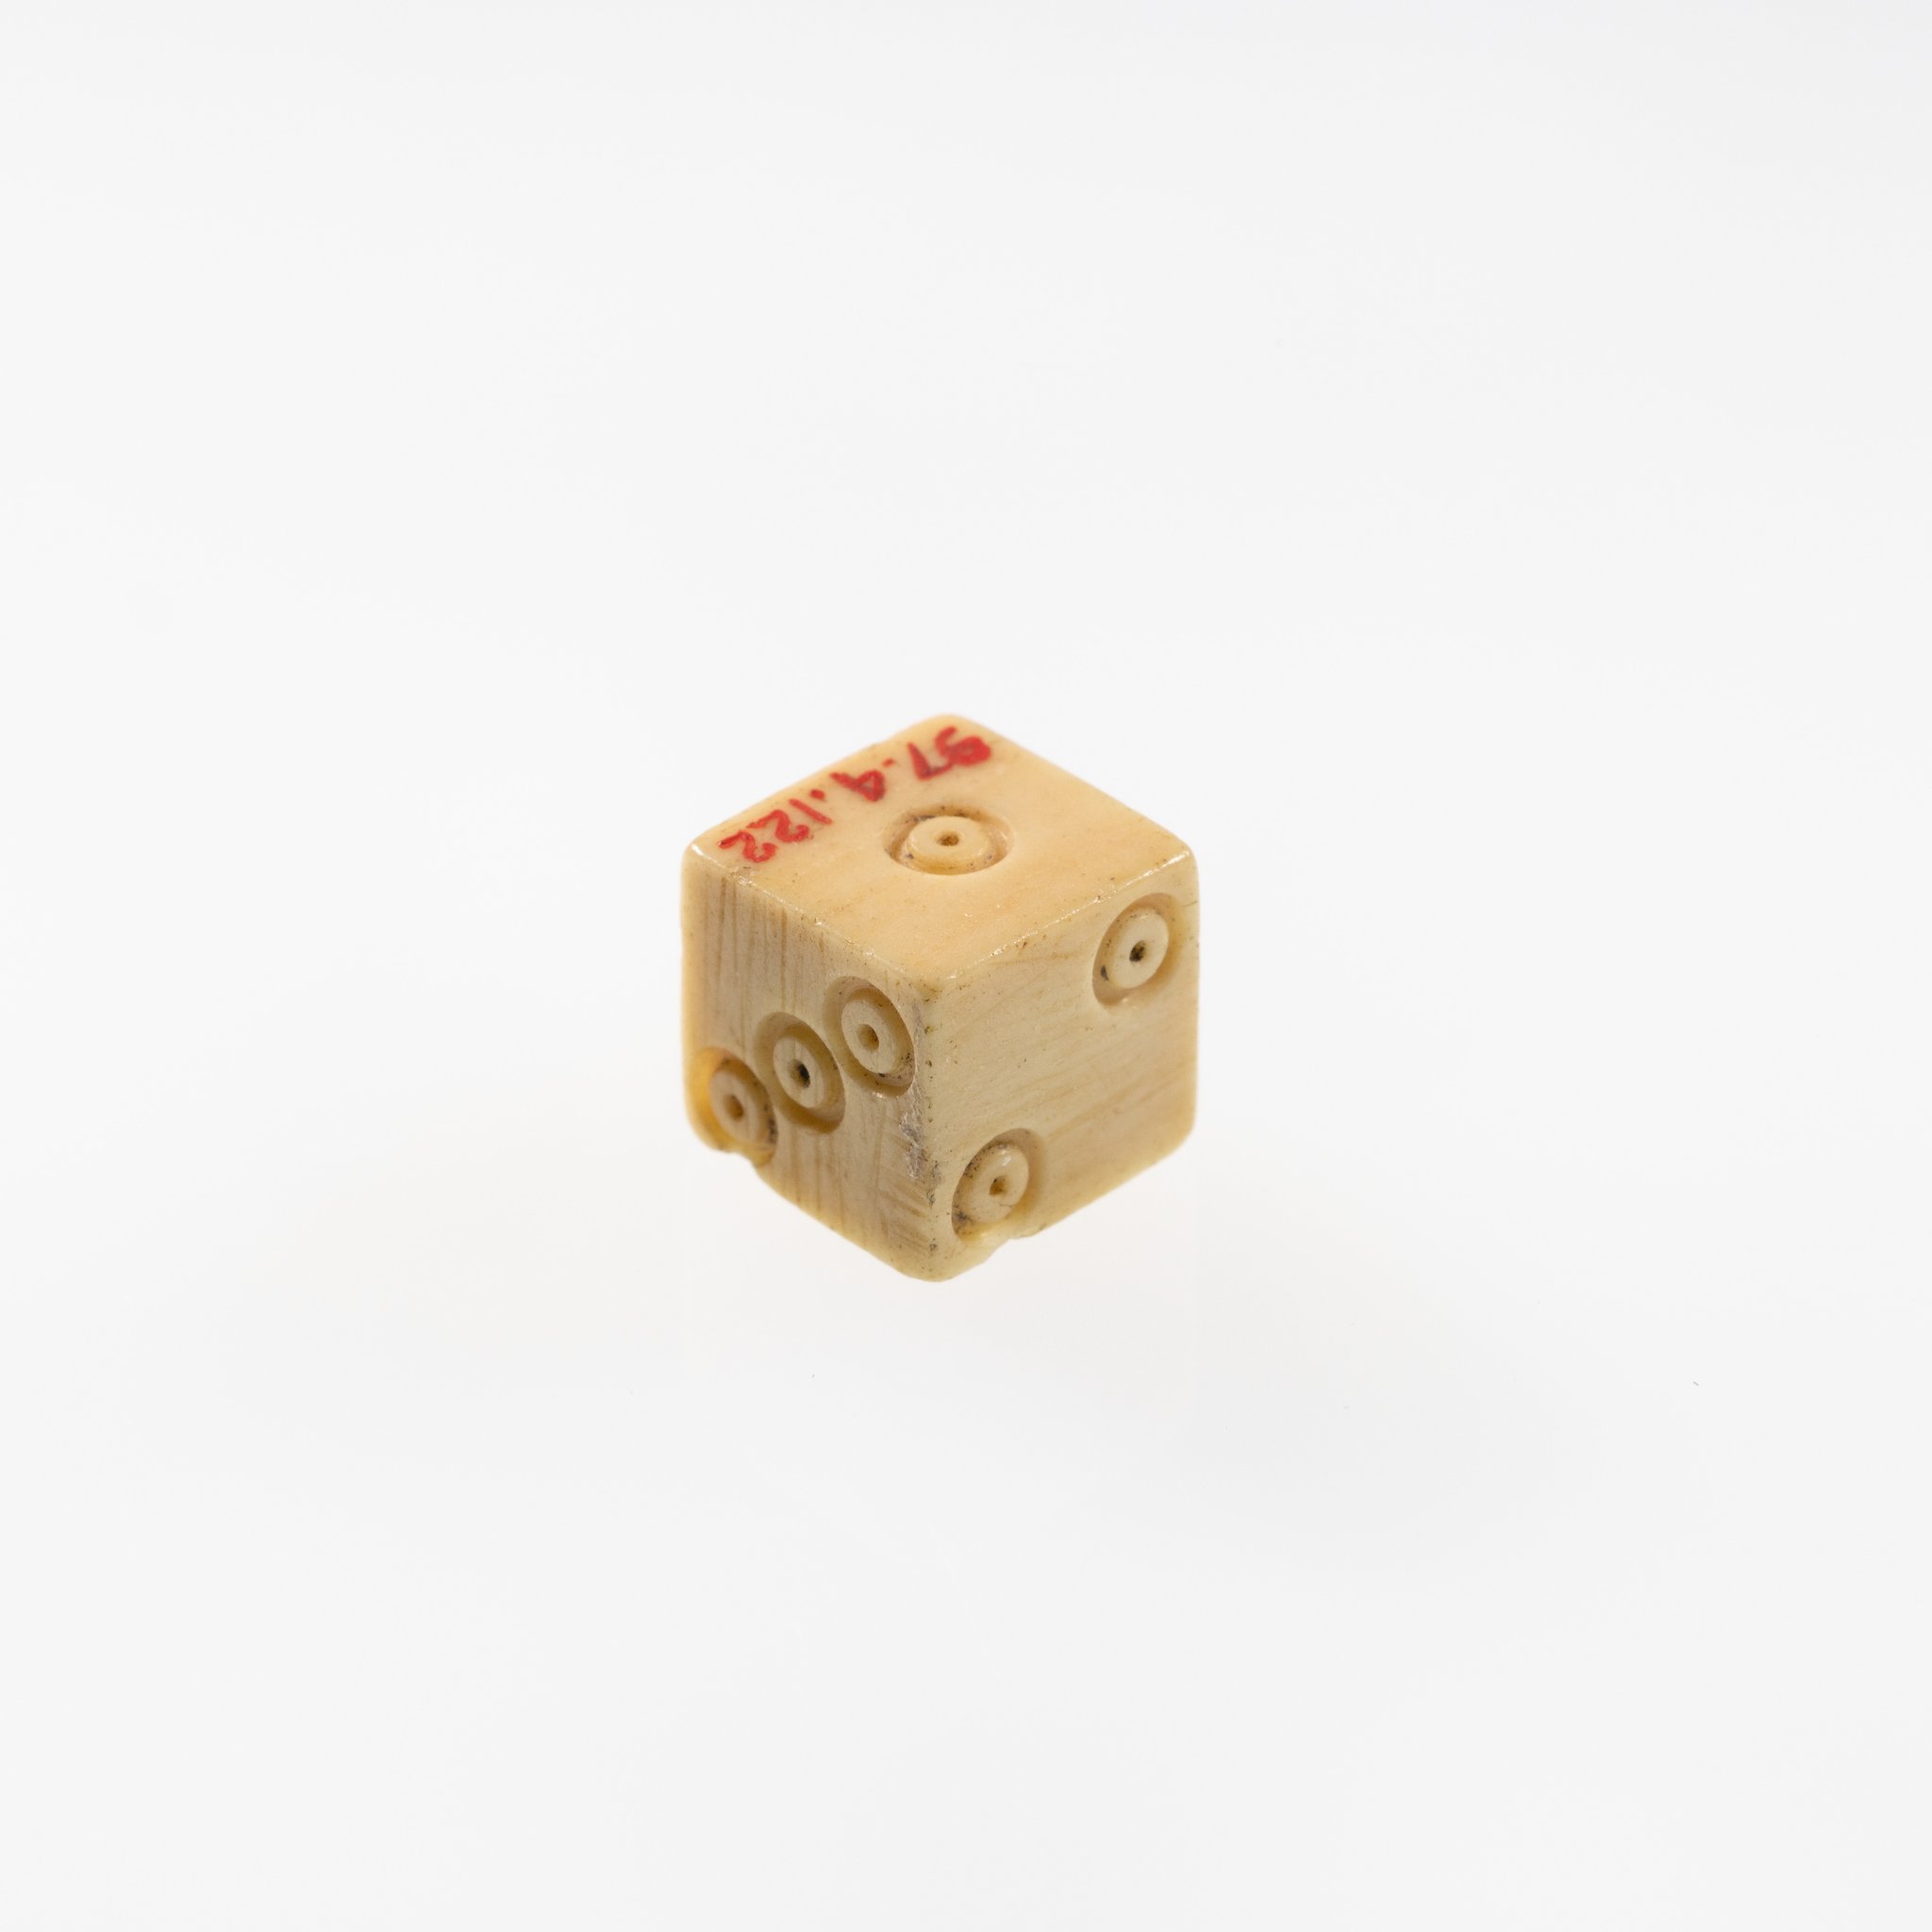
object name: dice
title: Die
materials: ivory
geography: egypt